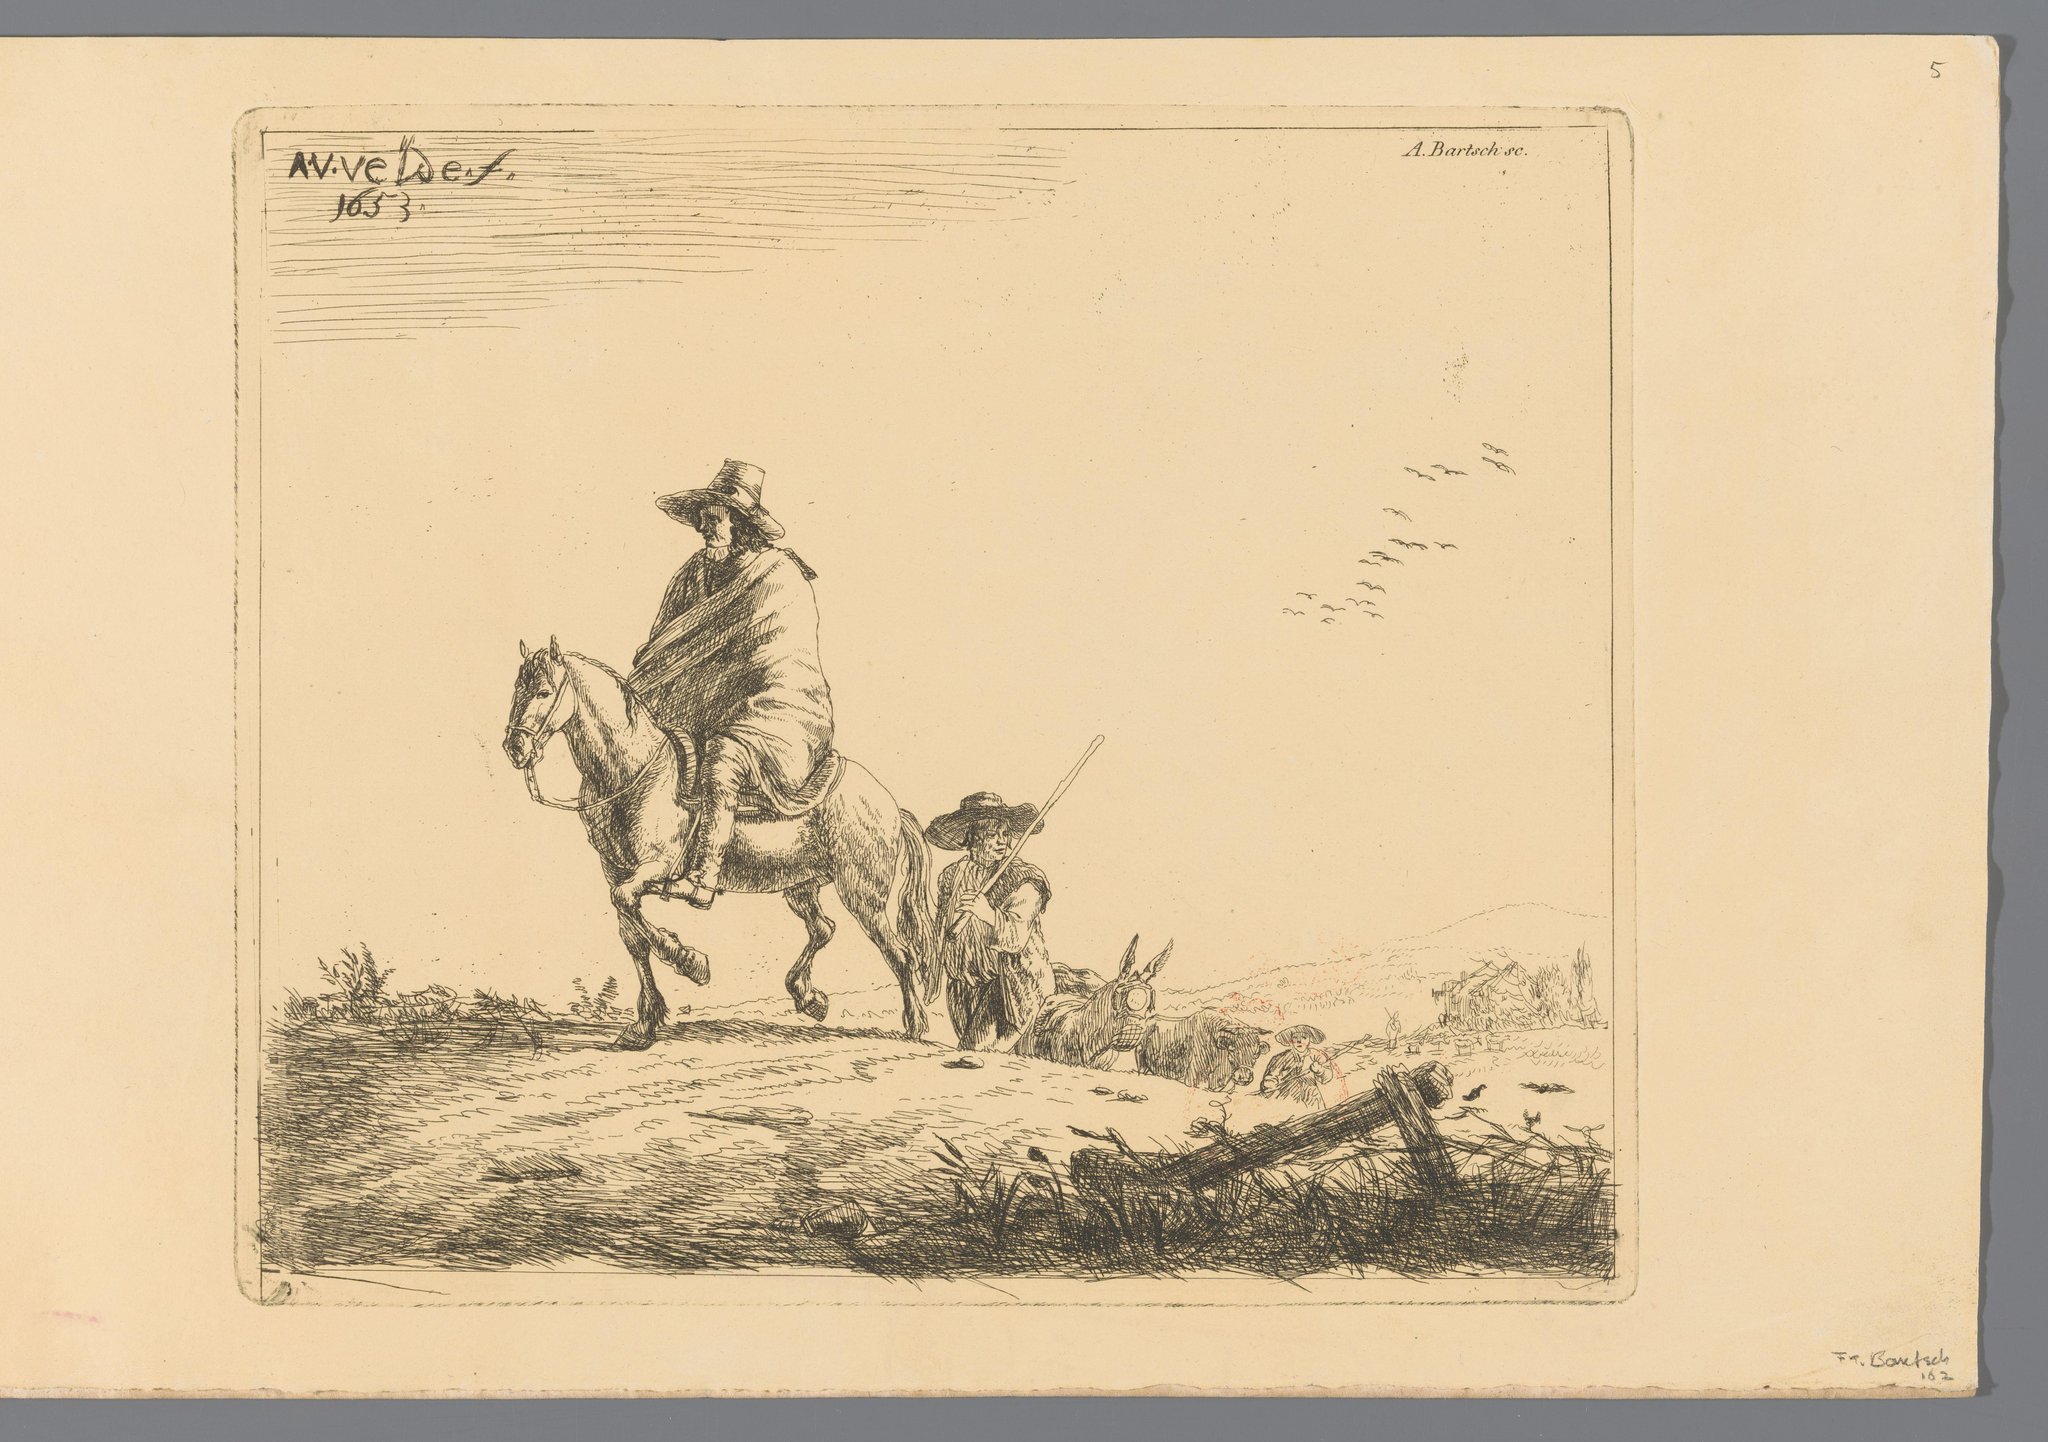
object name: print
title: Ruiter en herders met vee op zandweg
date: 1803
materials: paper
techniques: etching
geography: vienna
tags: mule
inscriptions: collector's mark: Lugt 12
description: Deze prent maakt deel uit van een album.